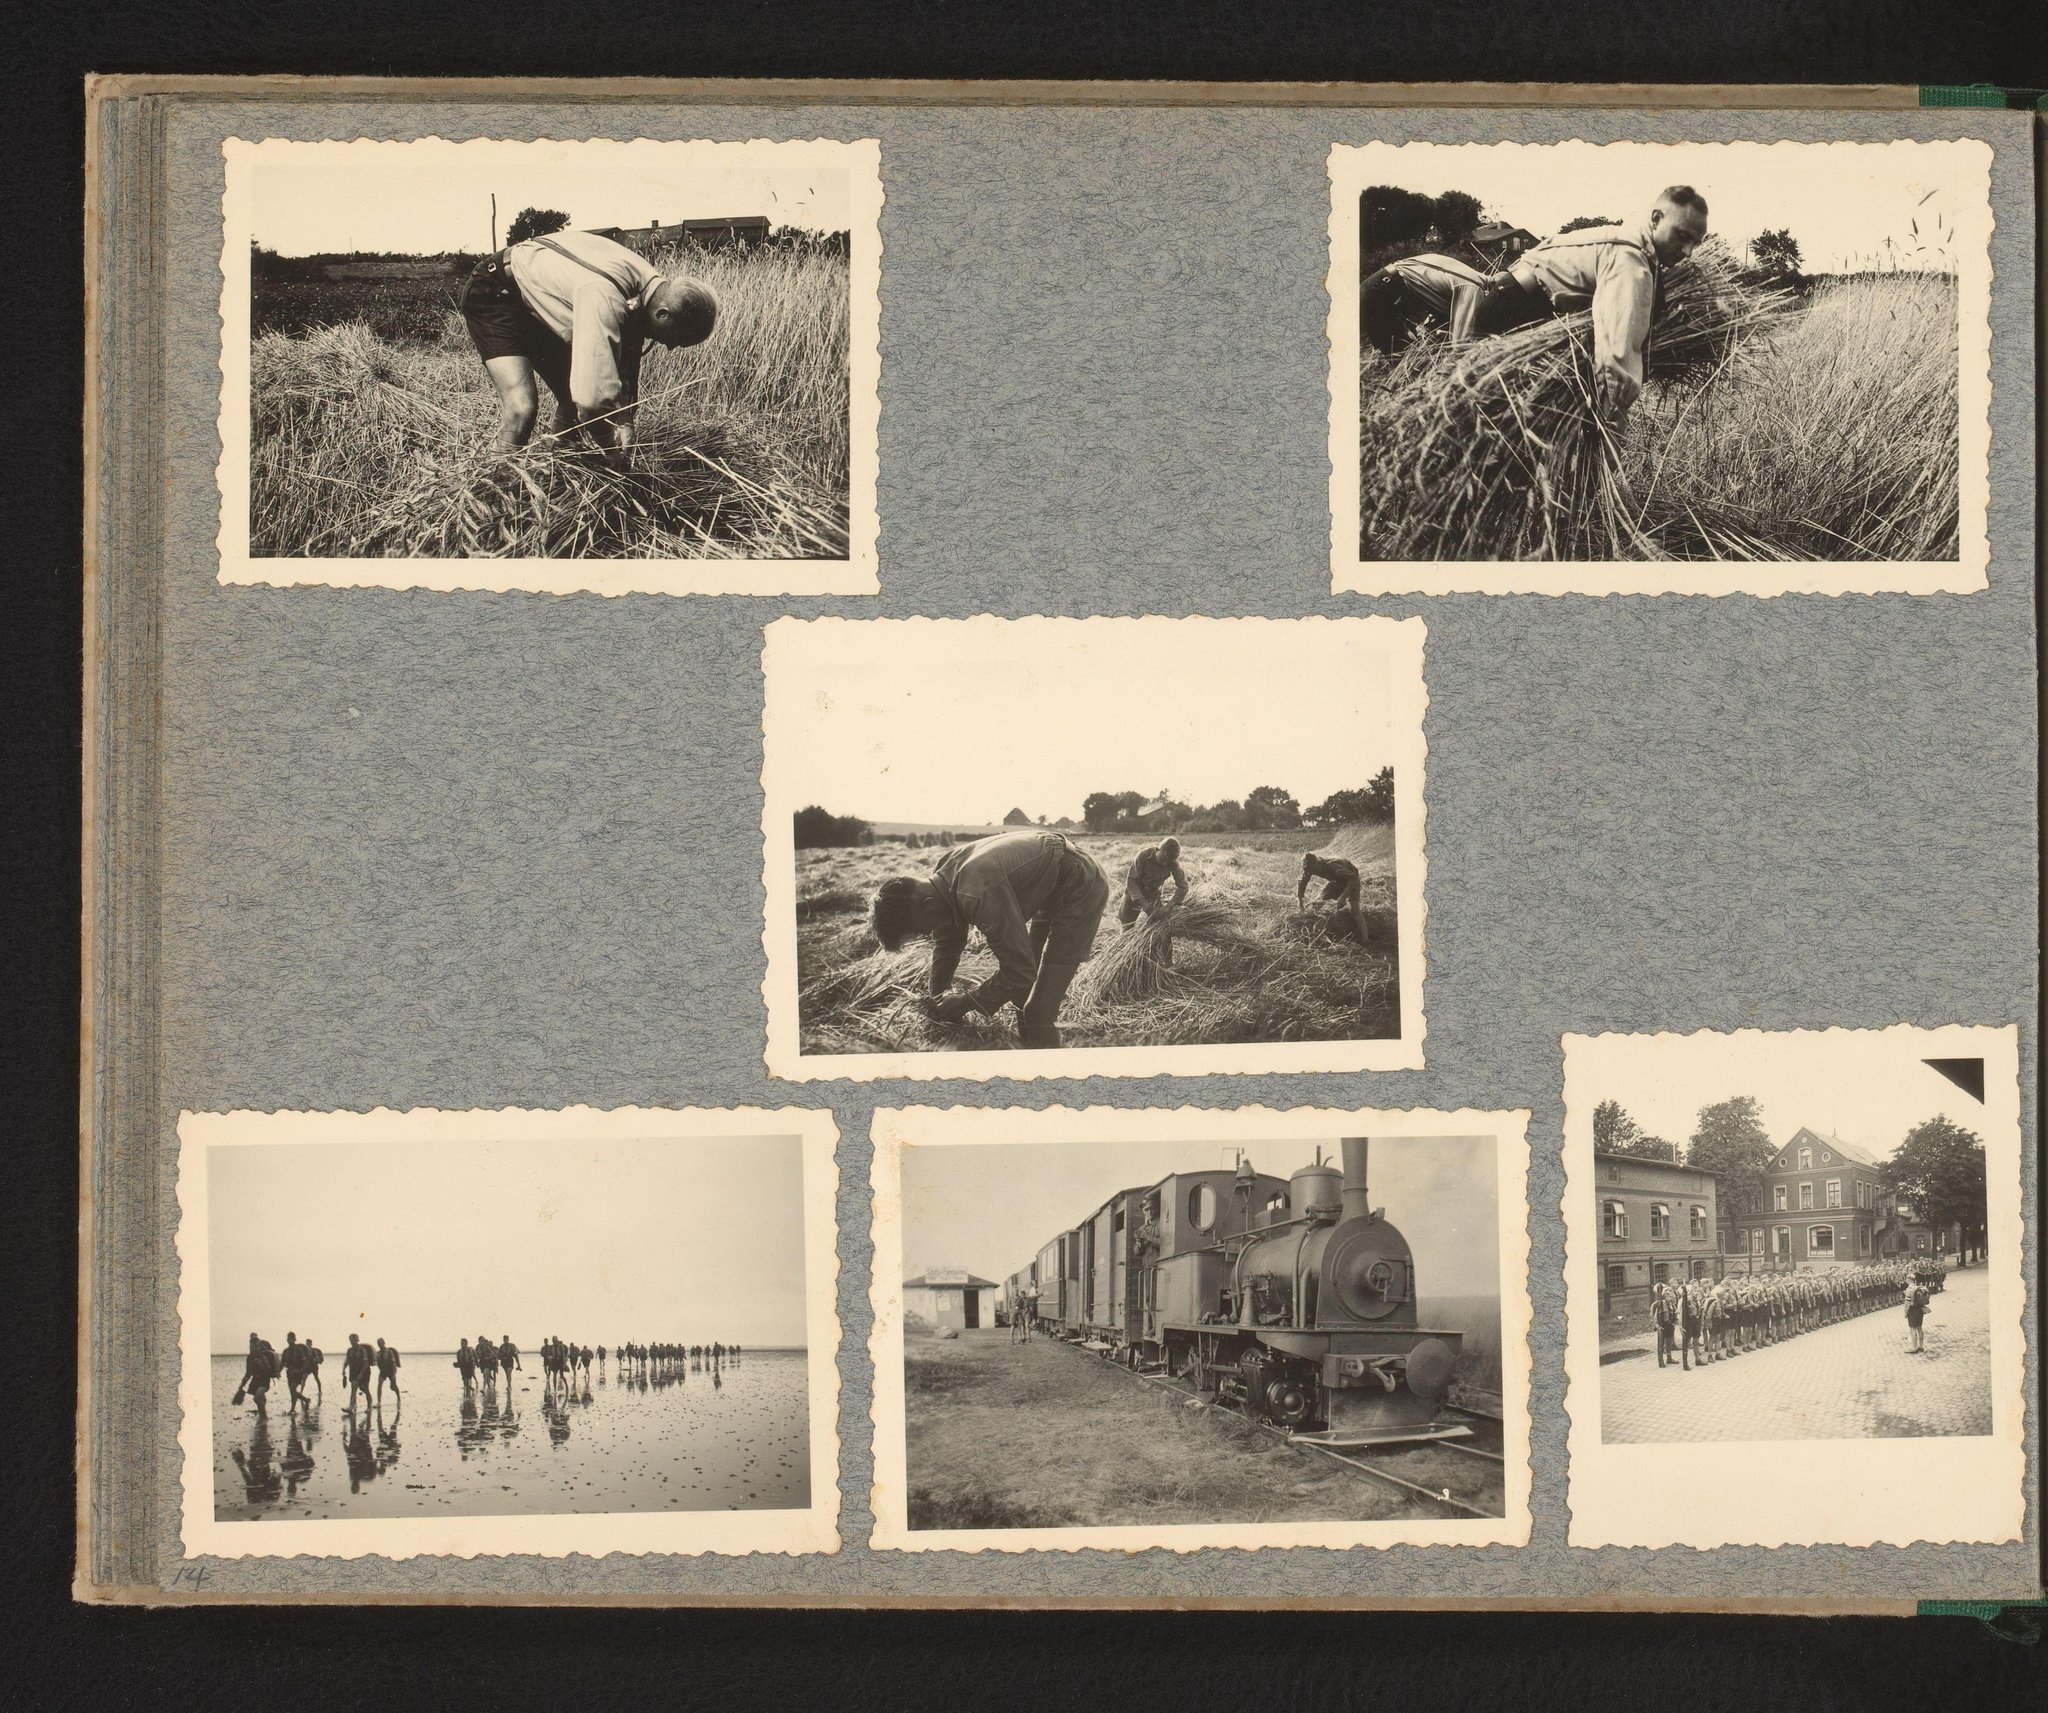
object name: photograph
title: Werken op het land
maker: Anonymous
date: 1935-1938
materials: cardboard, photographic support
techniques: gelatin silver print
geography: germany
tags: harvest, review, inspection (of company, unit, troop), passenger train, germany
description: Albumblad met zes foto's van het werk op het veld, een wandeltocht, trein en appel op de binnenplaats. Jongens van de Hitlerjugend van Landjahrlager 1935 in Wolmersdorf. Onderdeel van het Hitlerjugend fotoalbum.